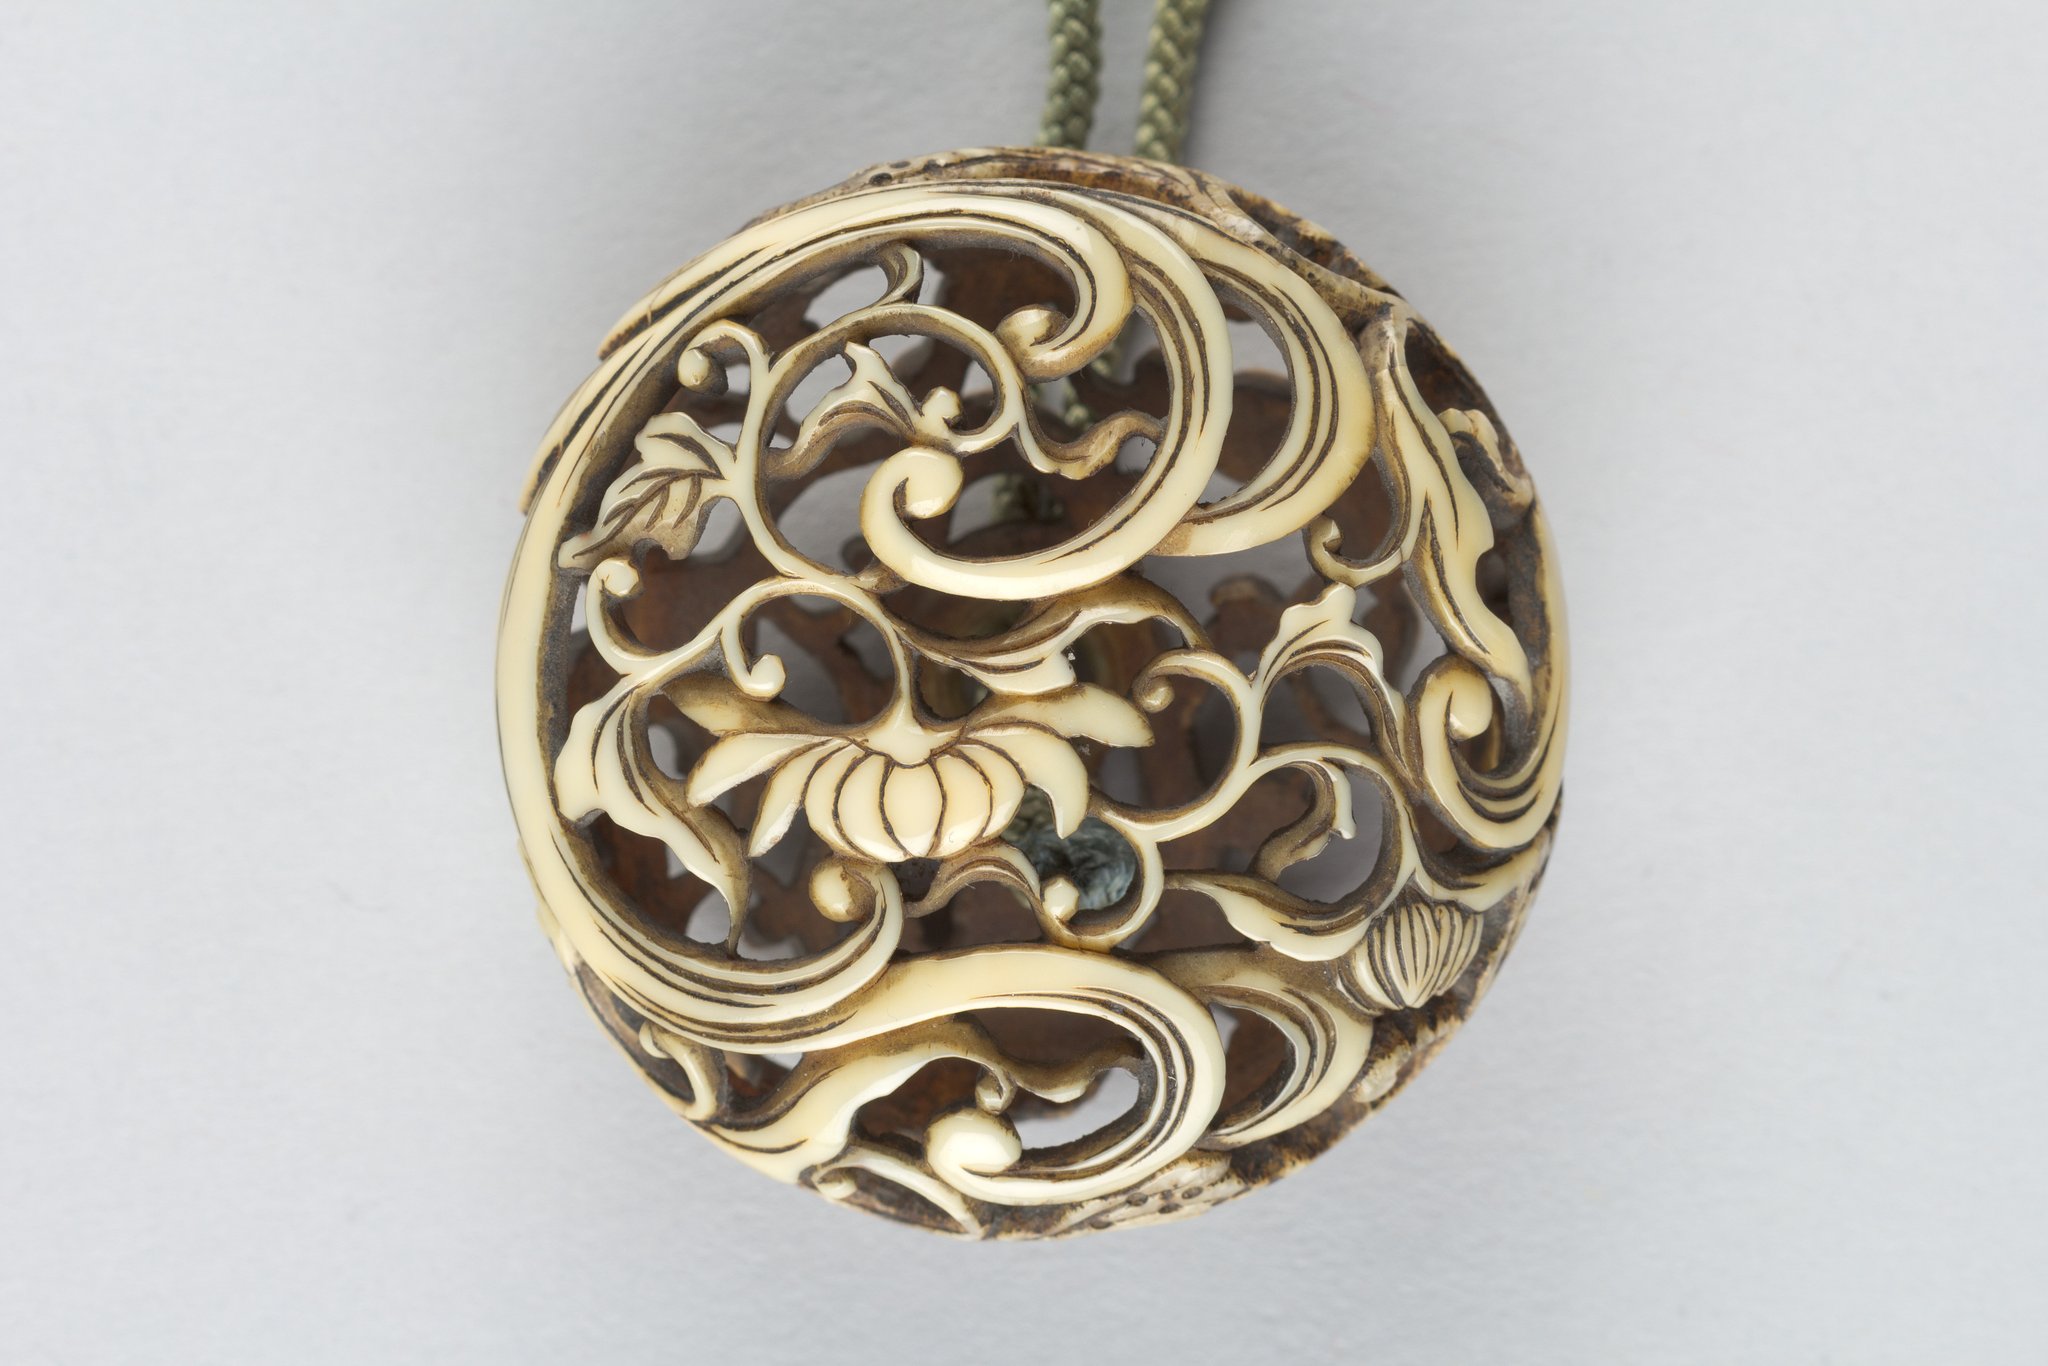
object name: netsuke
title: Netsuke of Water and Chrysanthemum (Kikusui)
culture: japanese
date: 1801-1900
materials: ivory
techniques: carving